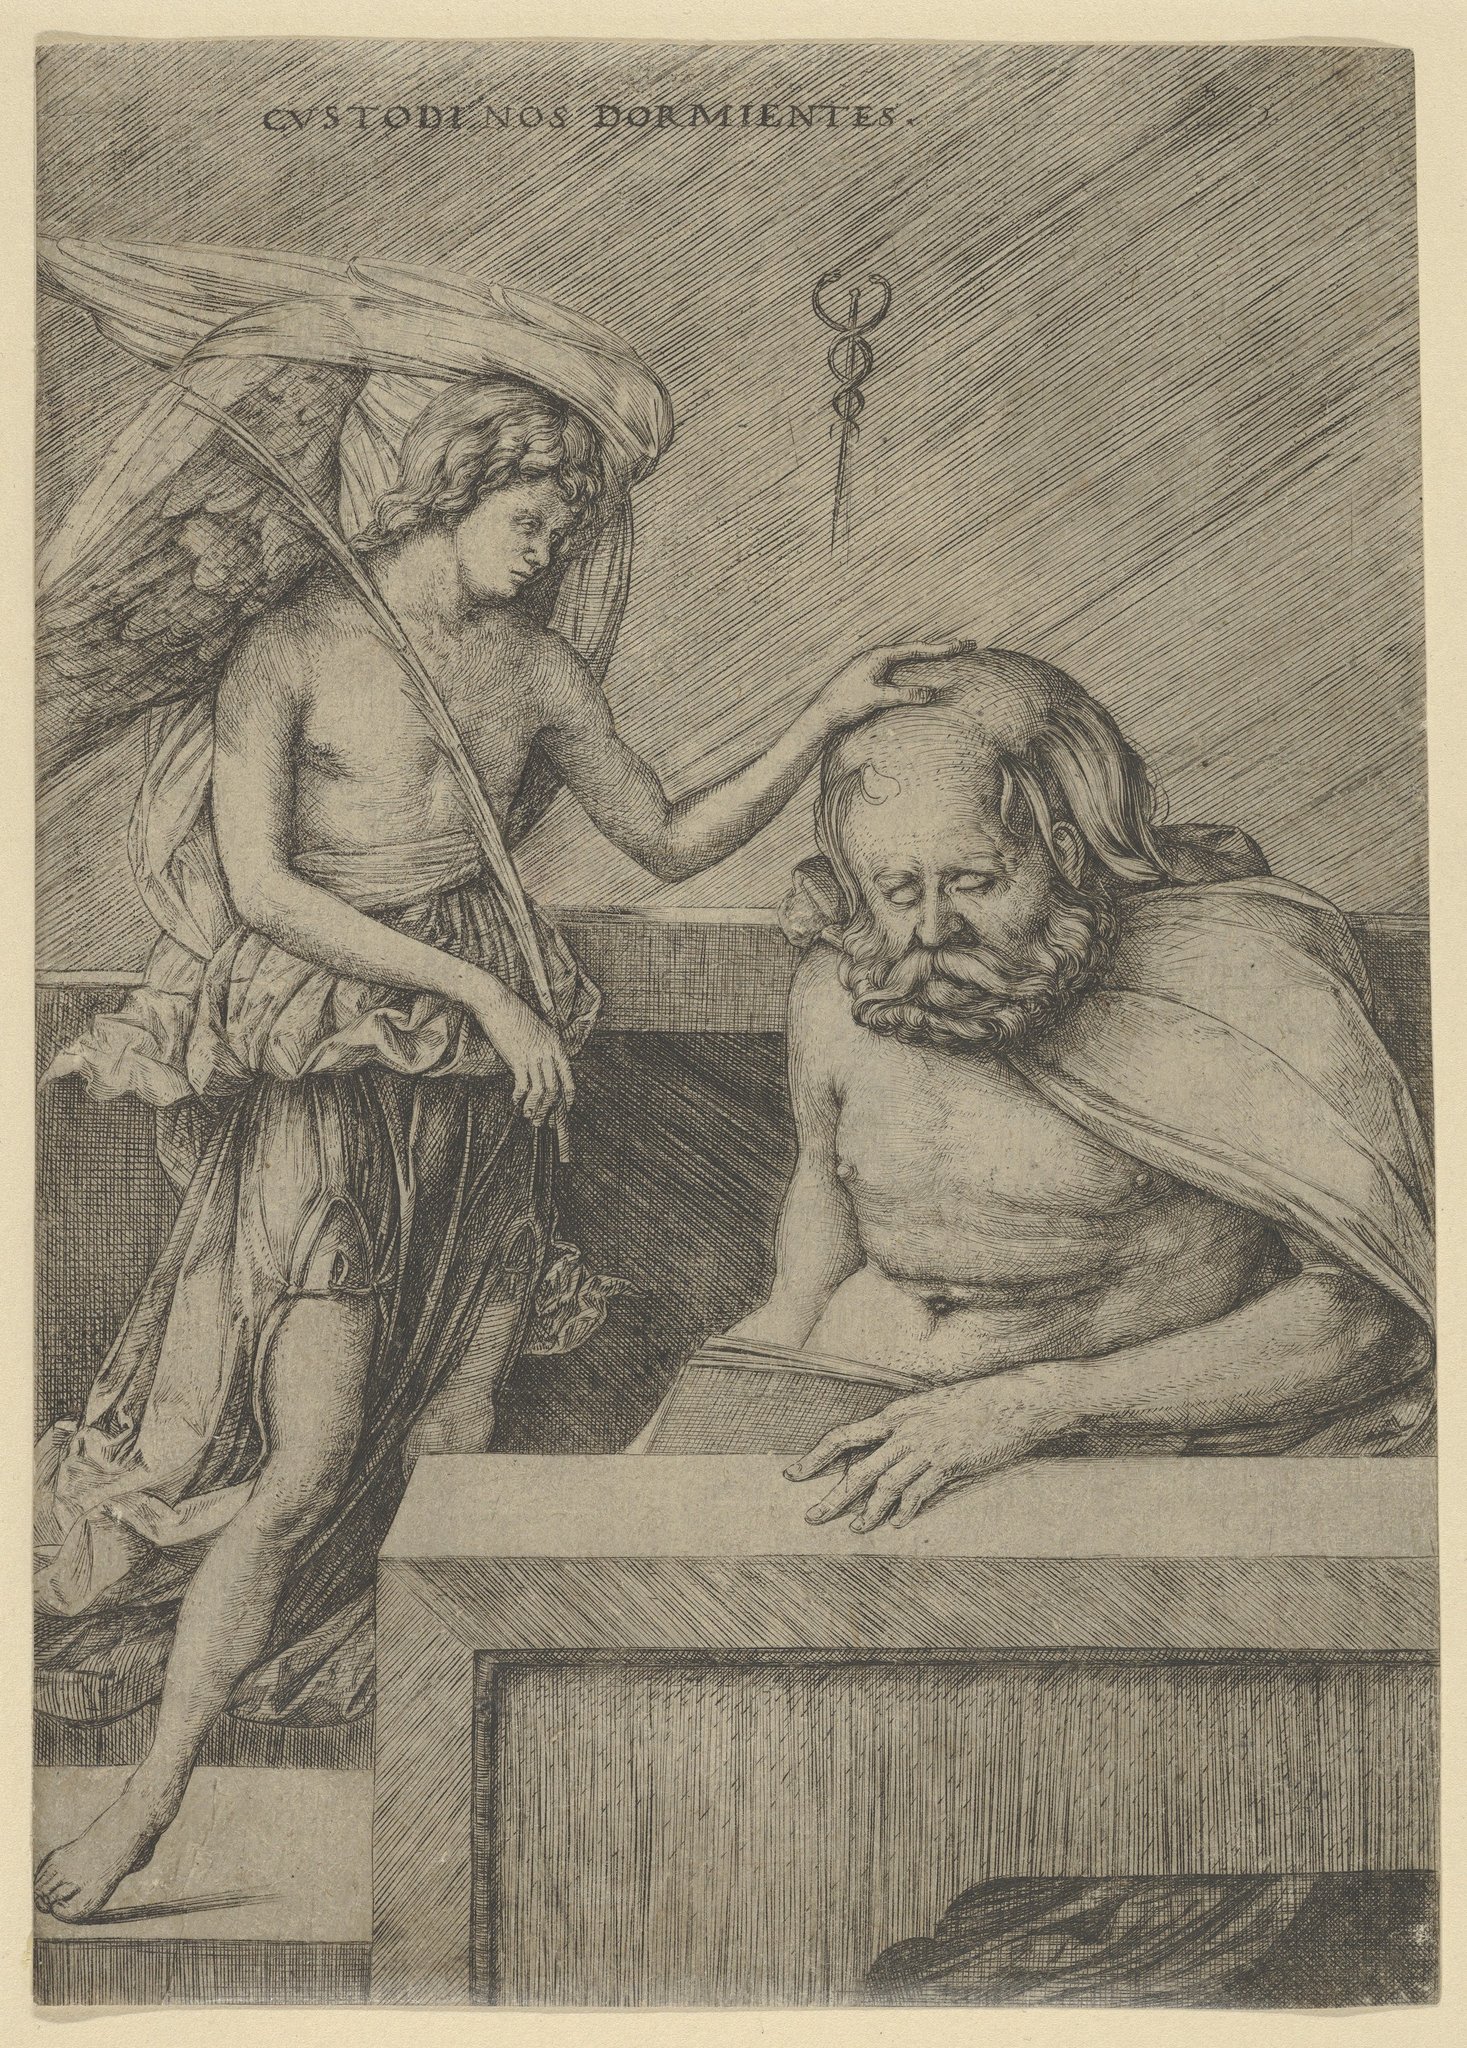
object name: print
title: The Guardian Angel: an angel at left placing his hand on the head of a sleeping seated man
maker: jacopo de barbari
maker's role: artist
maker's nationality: italian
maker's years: 1497-1516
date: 1500-1503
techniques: engraving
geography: venice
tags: men,angels